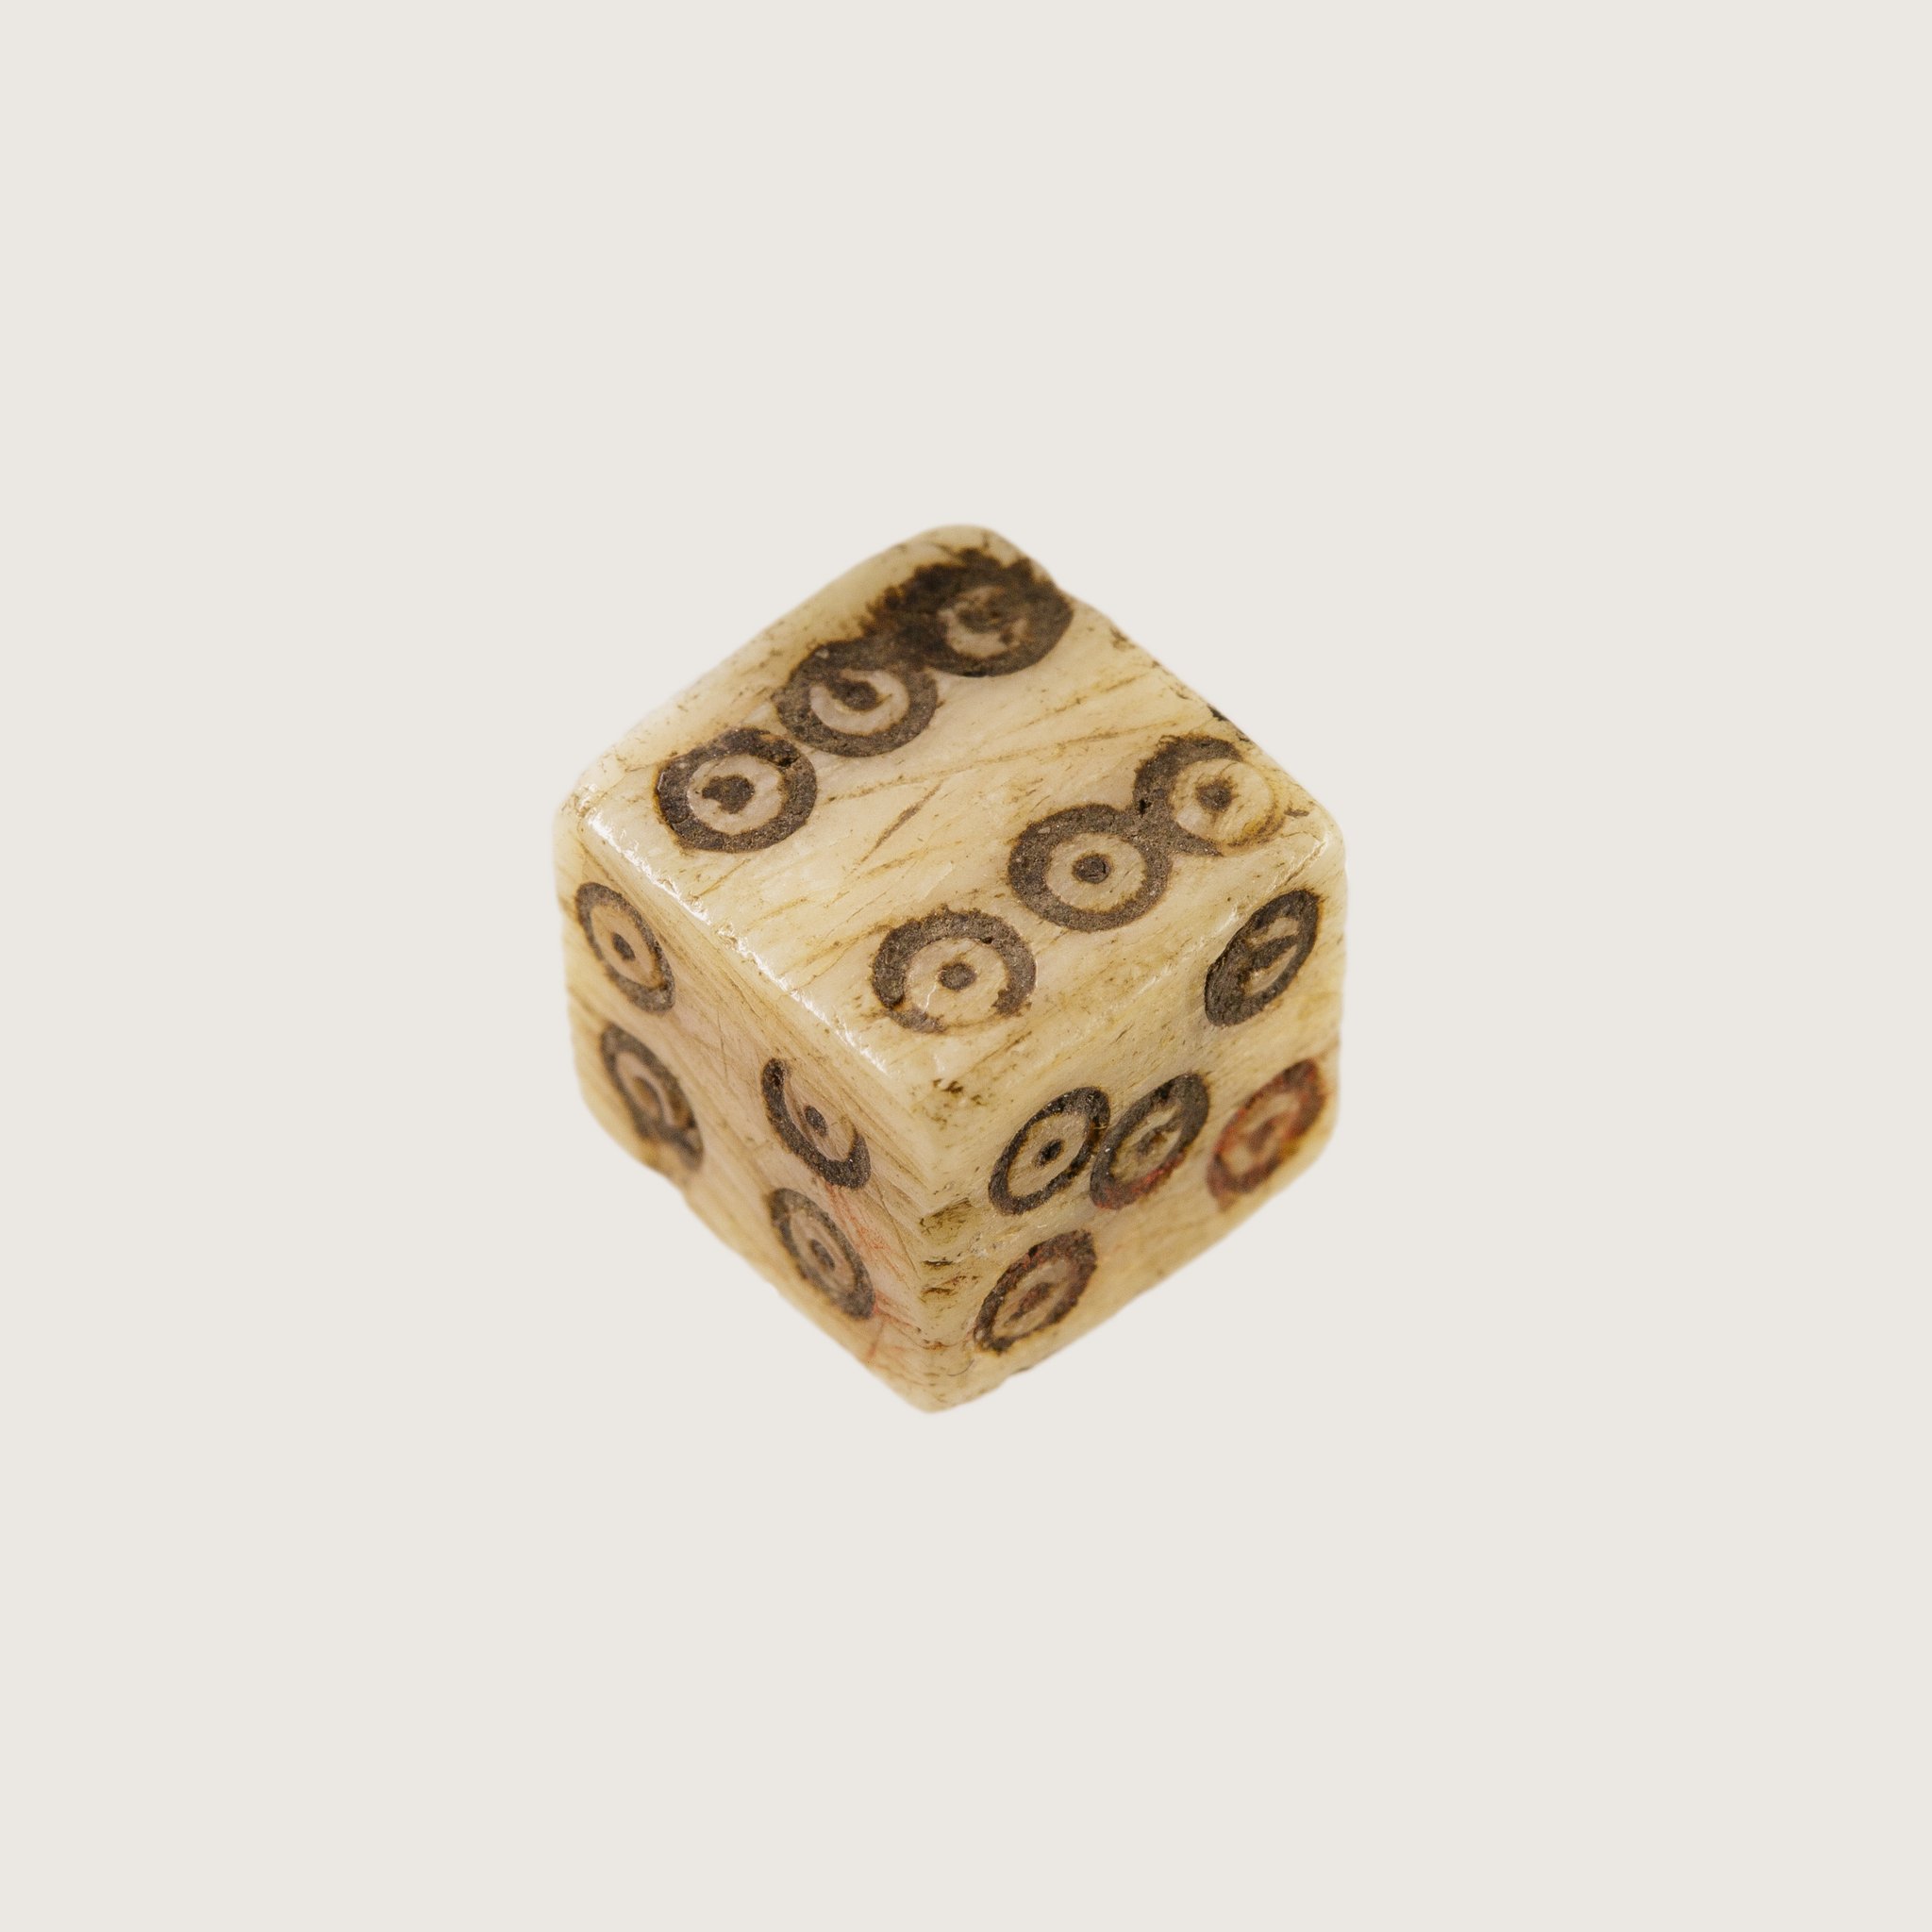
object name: dice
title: Die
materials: ivory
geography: egypt